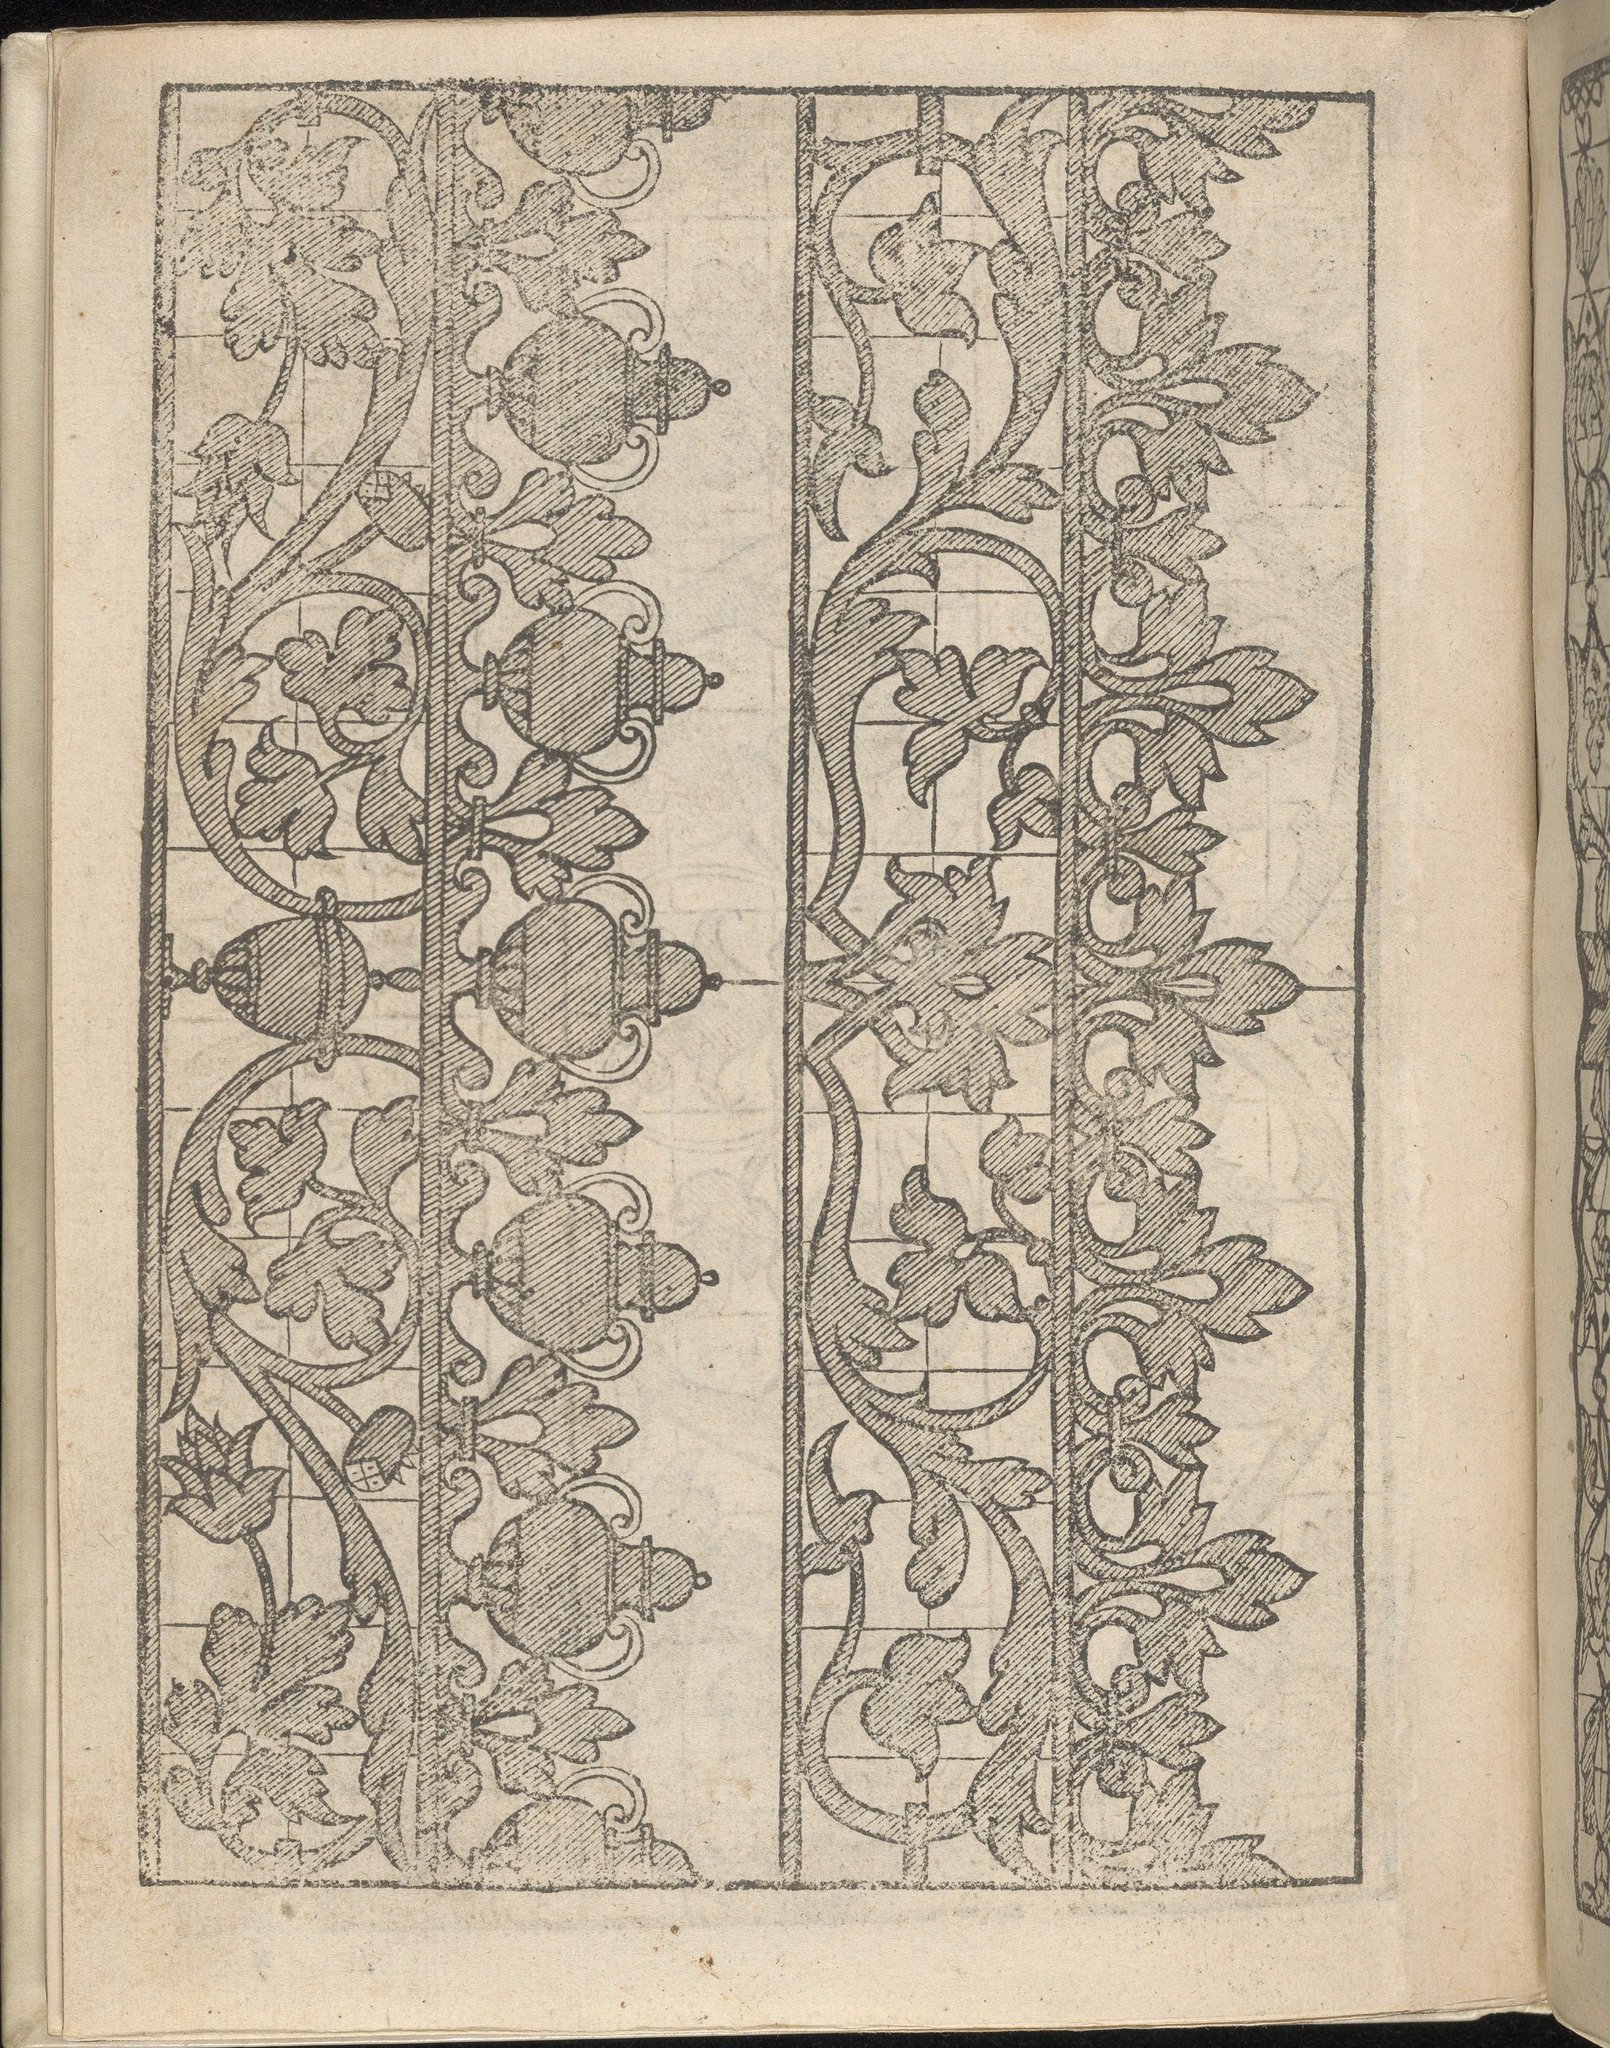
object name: book print ornament architecture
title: Lucidario di Recami, page 3 (recto)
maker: iseppo foresto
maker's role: designer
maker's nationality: italian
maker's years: 1520-1580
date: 1564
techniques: woodcut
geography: italy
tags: vines